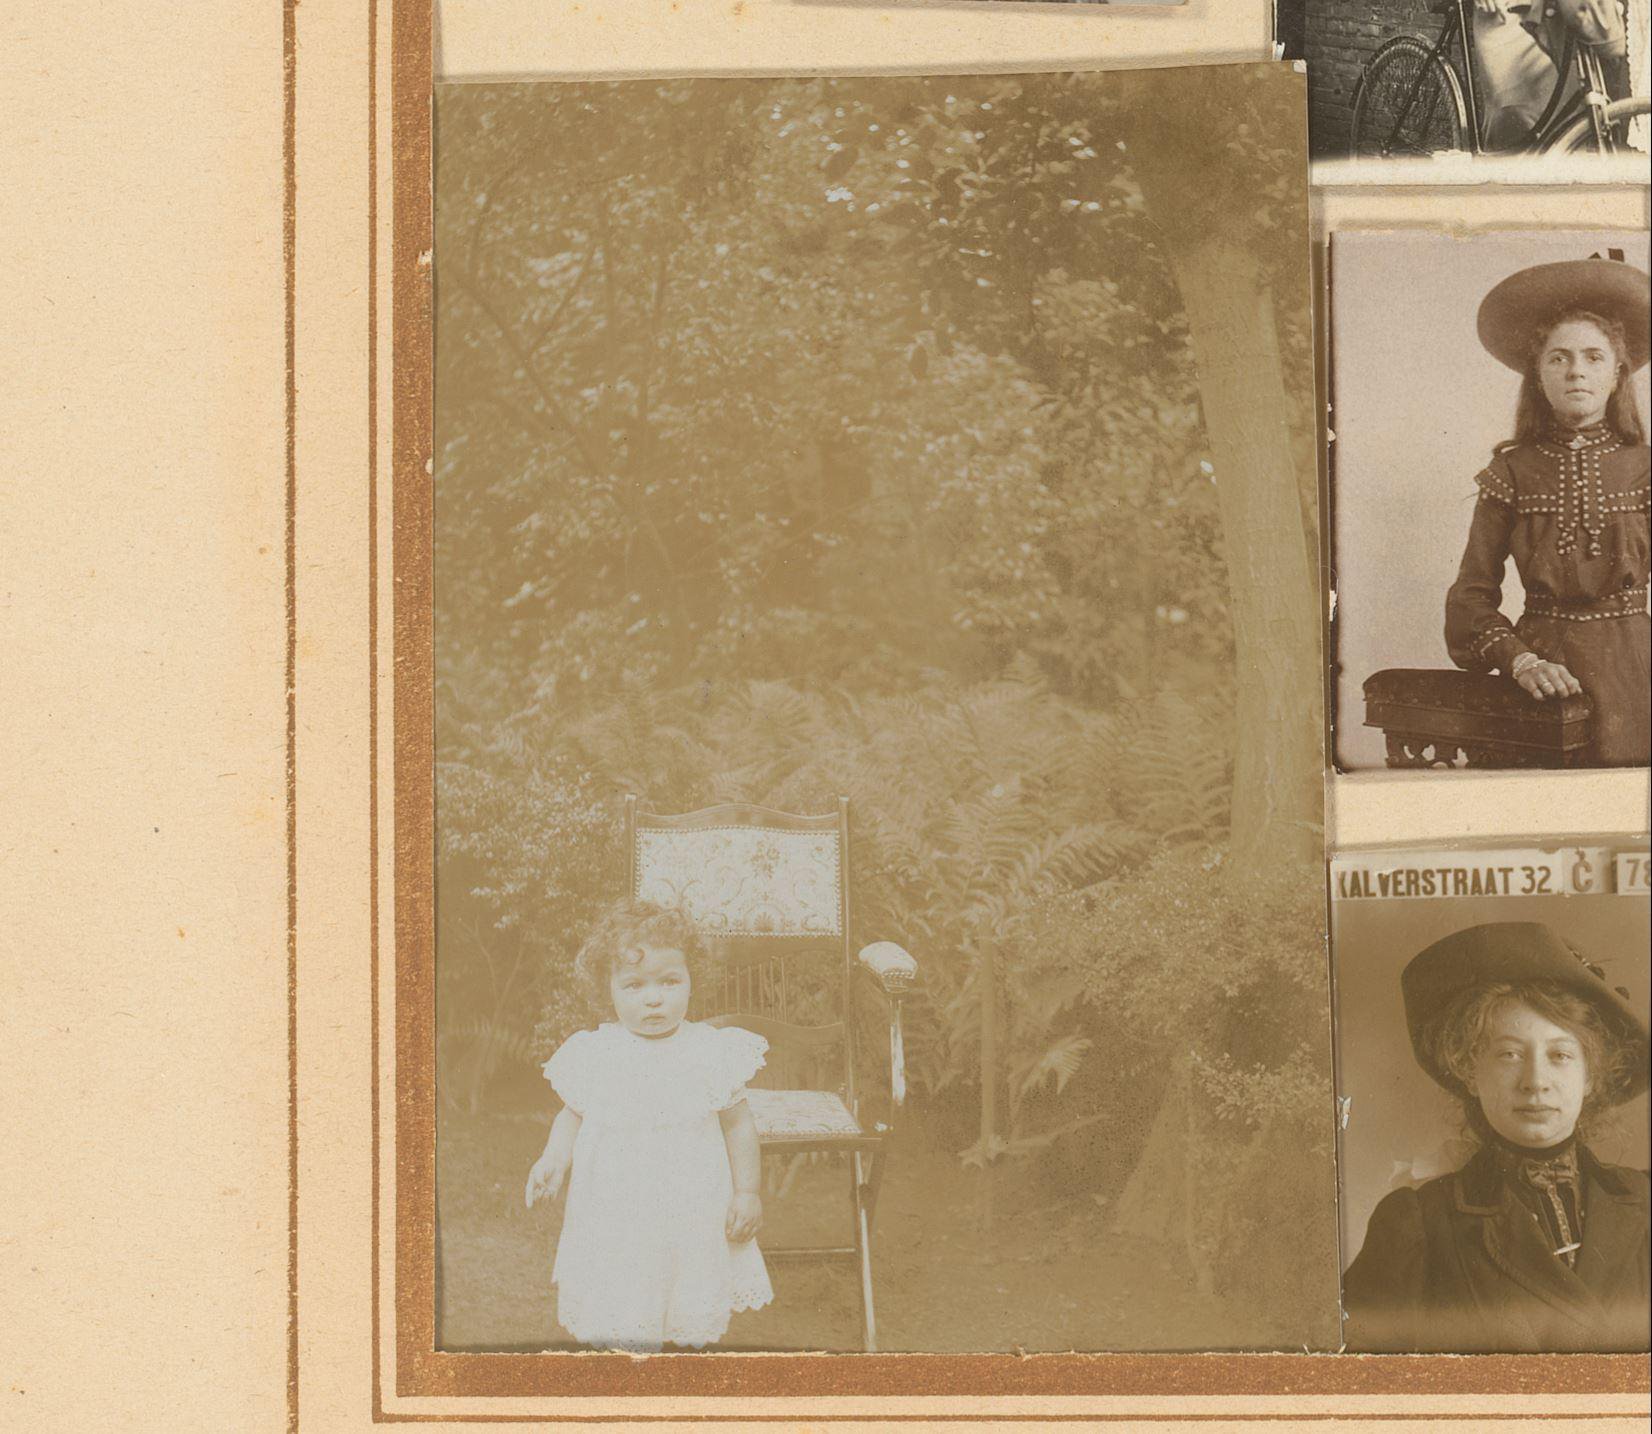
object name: photograph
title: Portret van een meisje, buiten bij een stoel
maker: Anonymous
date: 1880-1920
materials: photographic support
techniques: collodion silver print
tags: girl (child between toddler and youth)